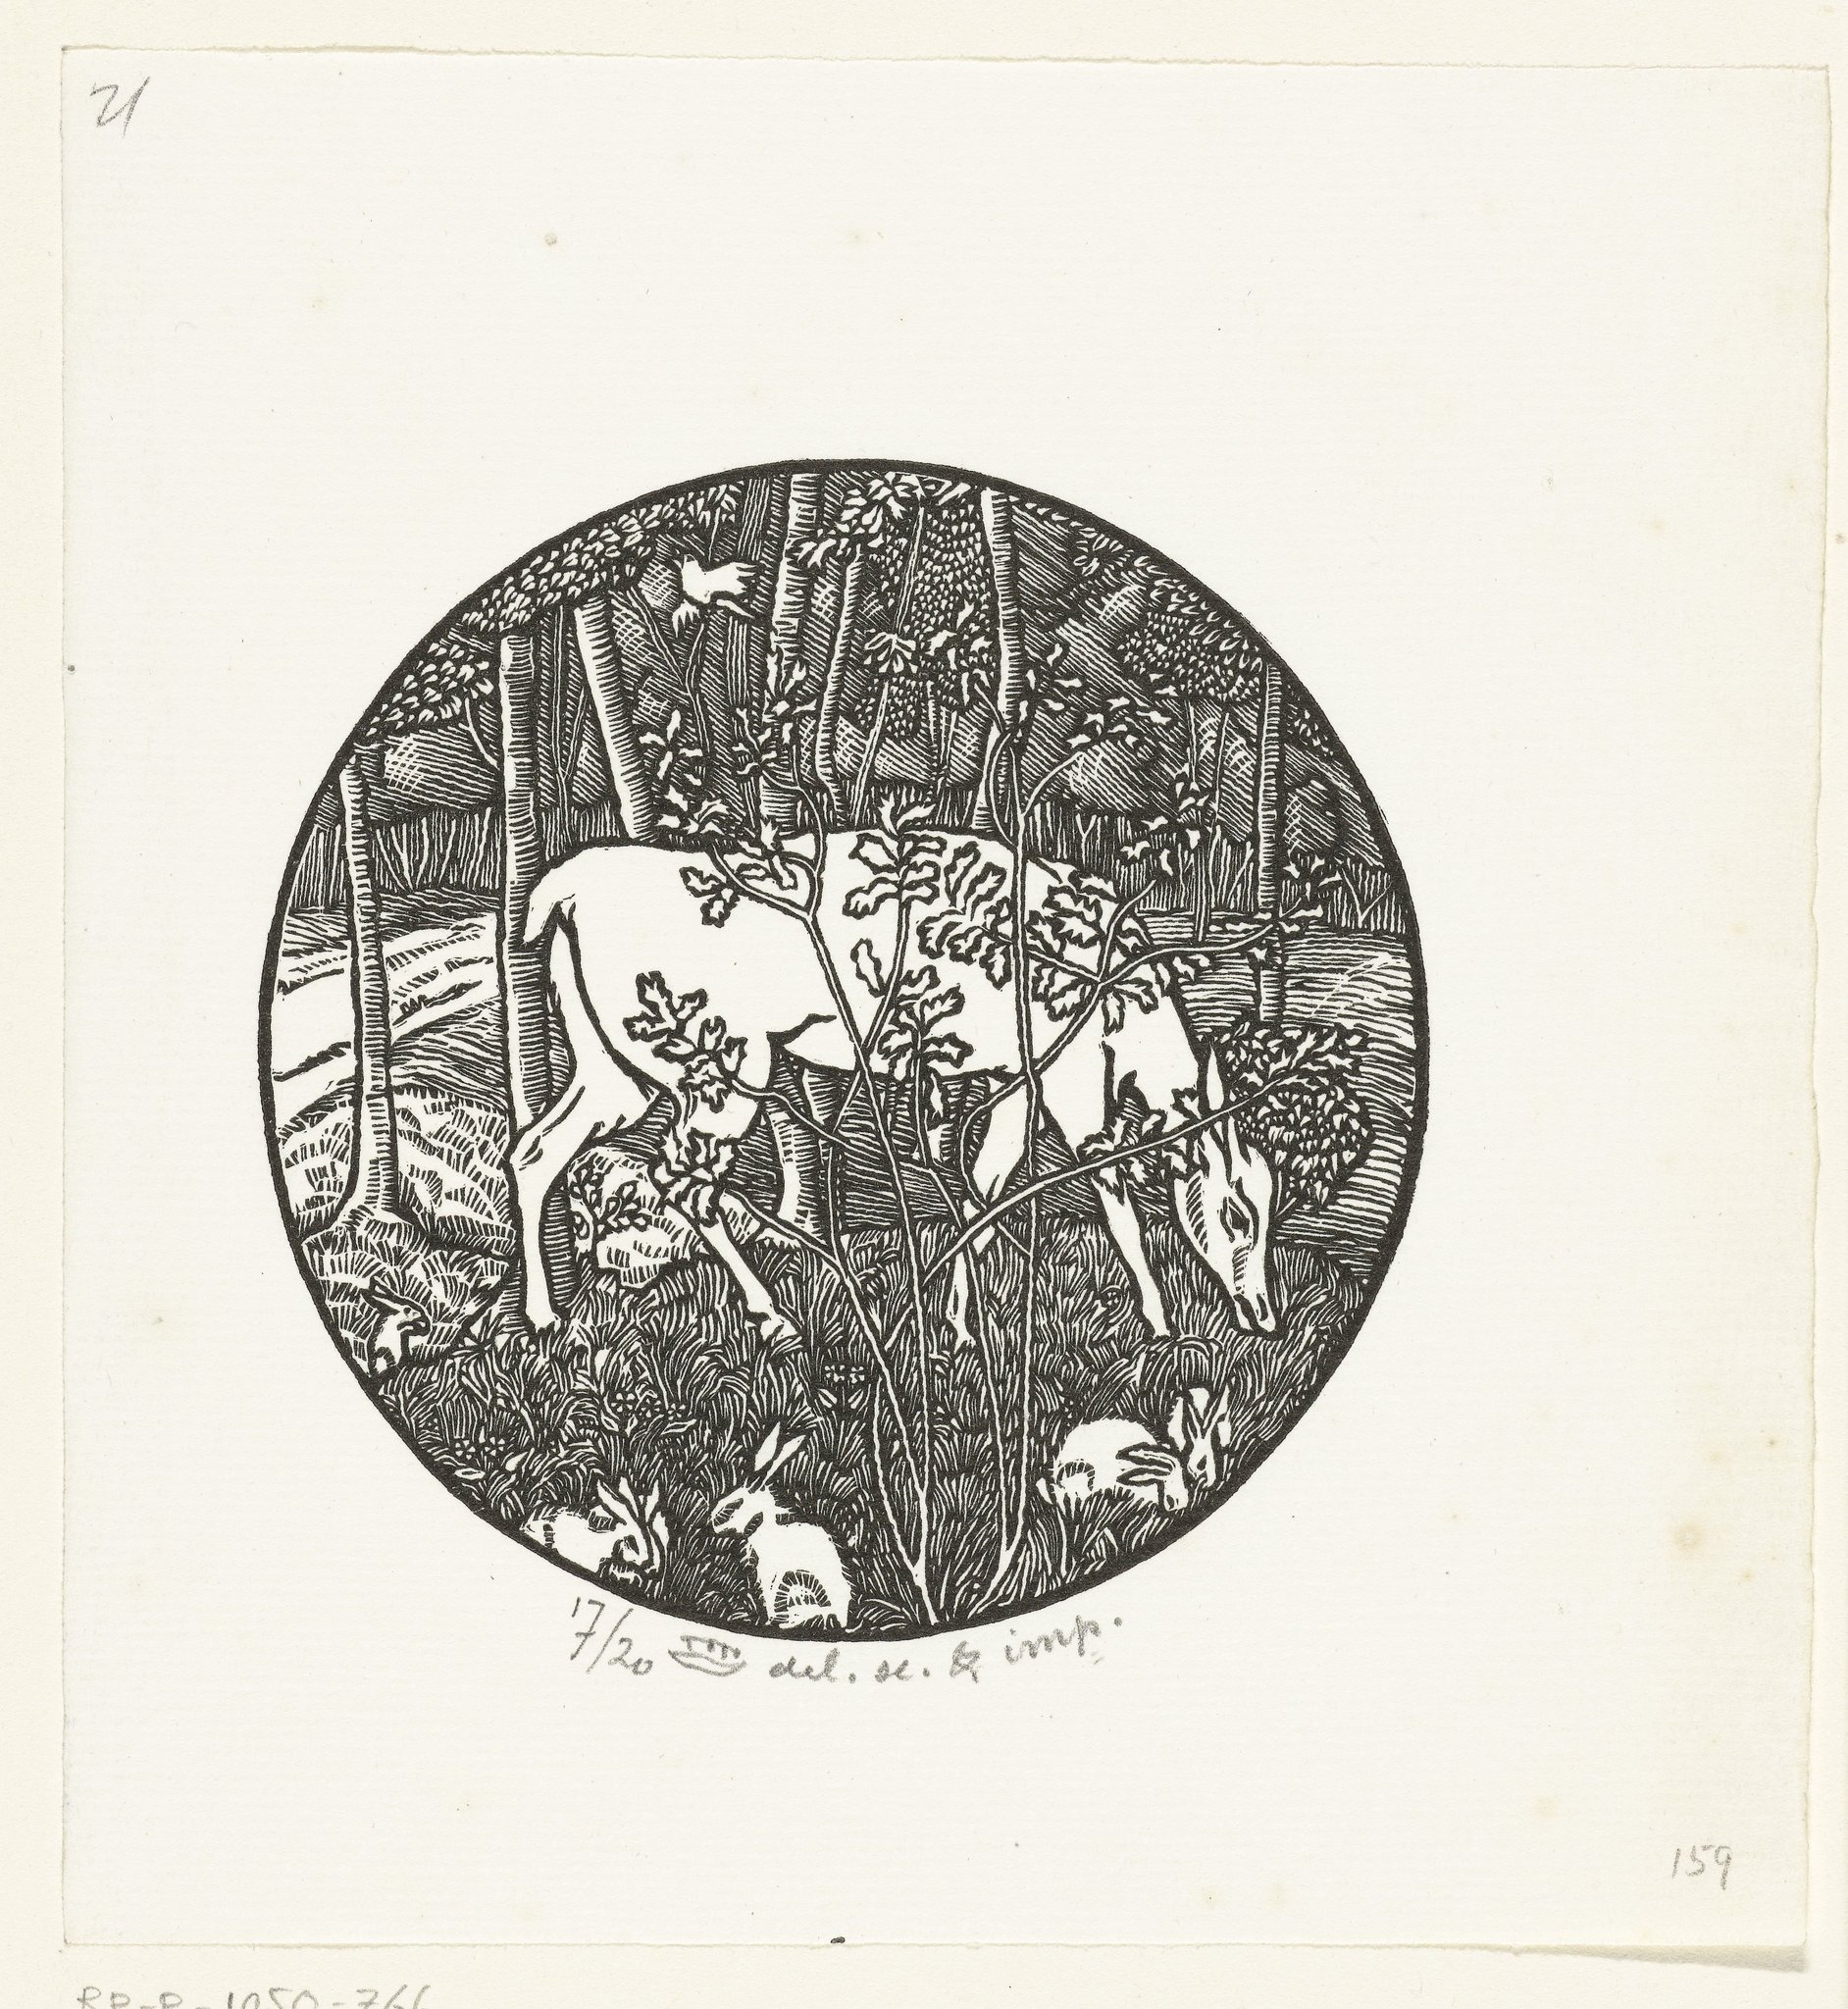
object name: print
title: Grazend hert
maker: lucien pissarro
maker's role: painter, print maker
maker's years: 1863-1944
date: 1899-1900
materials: paper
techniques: engraving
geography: england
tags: hoofed animals: deer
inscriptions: collector's mark: Lugt 2228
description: Houtgrave is gemaakt als boekillustratie voor Gustave Flaubert's "La légende de St. Julien l'Hospitalier", gedrukt bij Eragny (drukkerij van Lucien en Esther Pissarro) in 1900 en werd verkocht bij Hacon en Ricketts. K.Botke